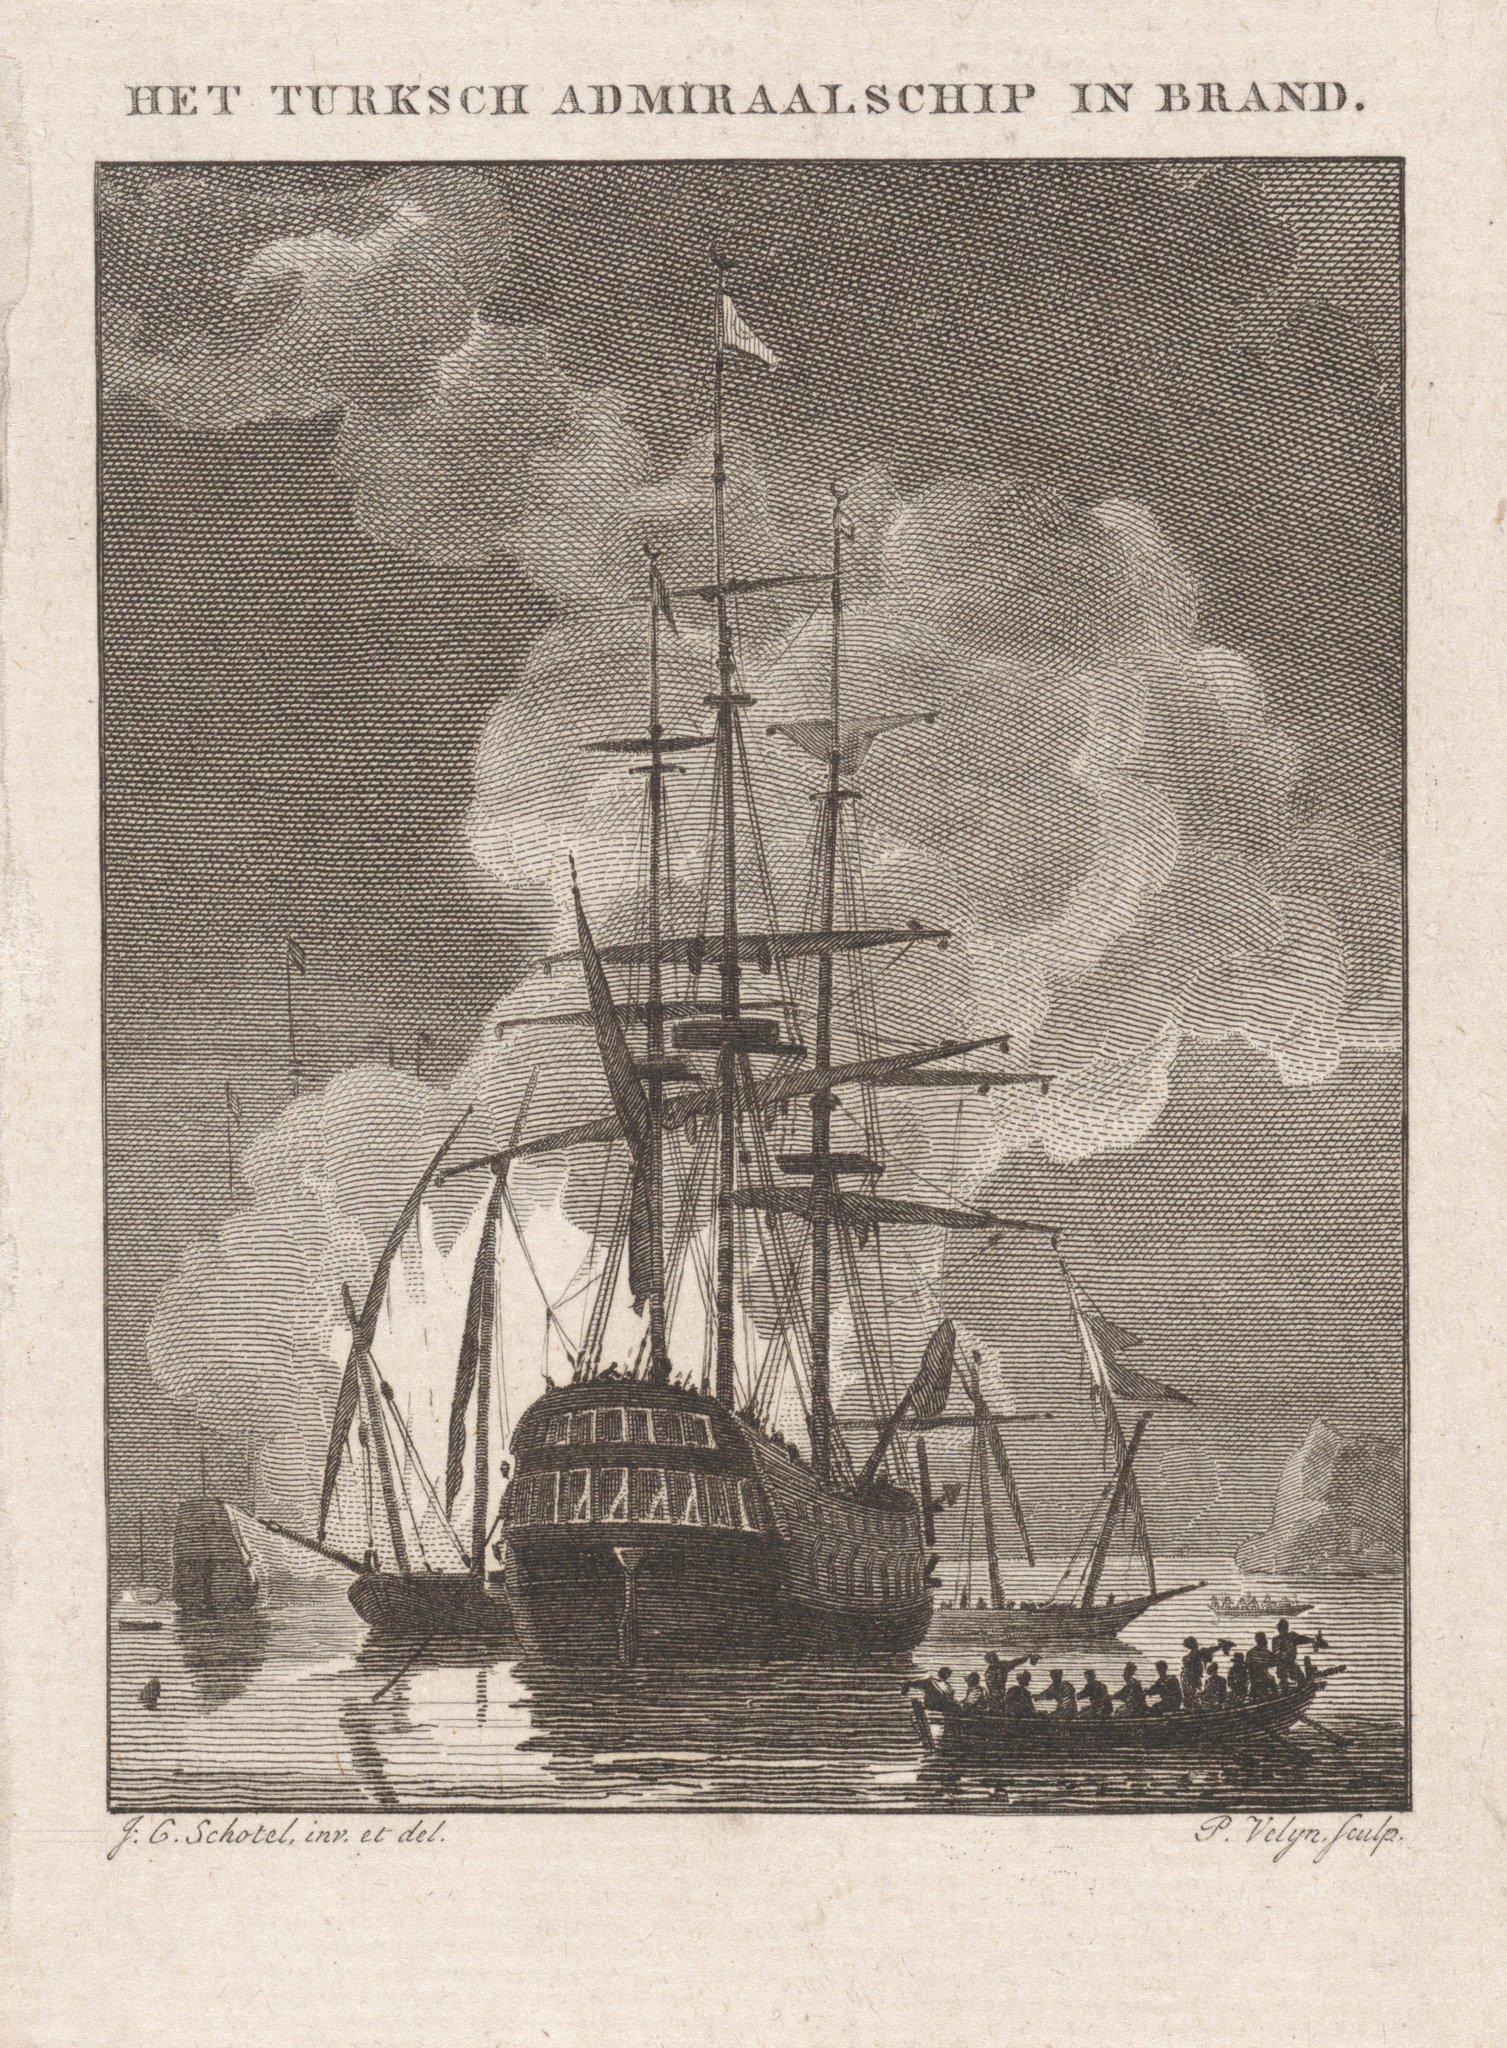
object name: print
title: Het turksch admiraalschip in brand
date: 1824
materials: paper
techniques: engraving, etching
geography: netherlands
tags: sailing-ship, sailing-boat, rowing-boat, canoe, etc., burning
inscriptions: collector's mark: Lugt 2228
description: Prent ook gebruikt in: Nederlandsche Muzen-Almanak. Rotterdam: J. Immerzeel, 1824.